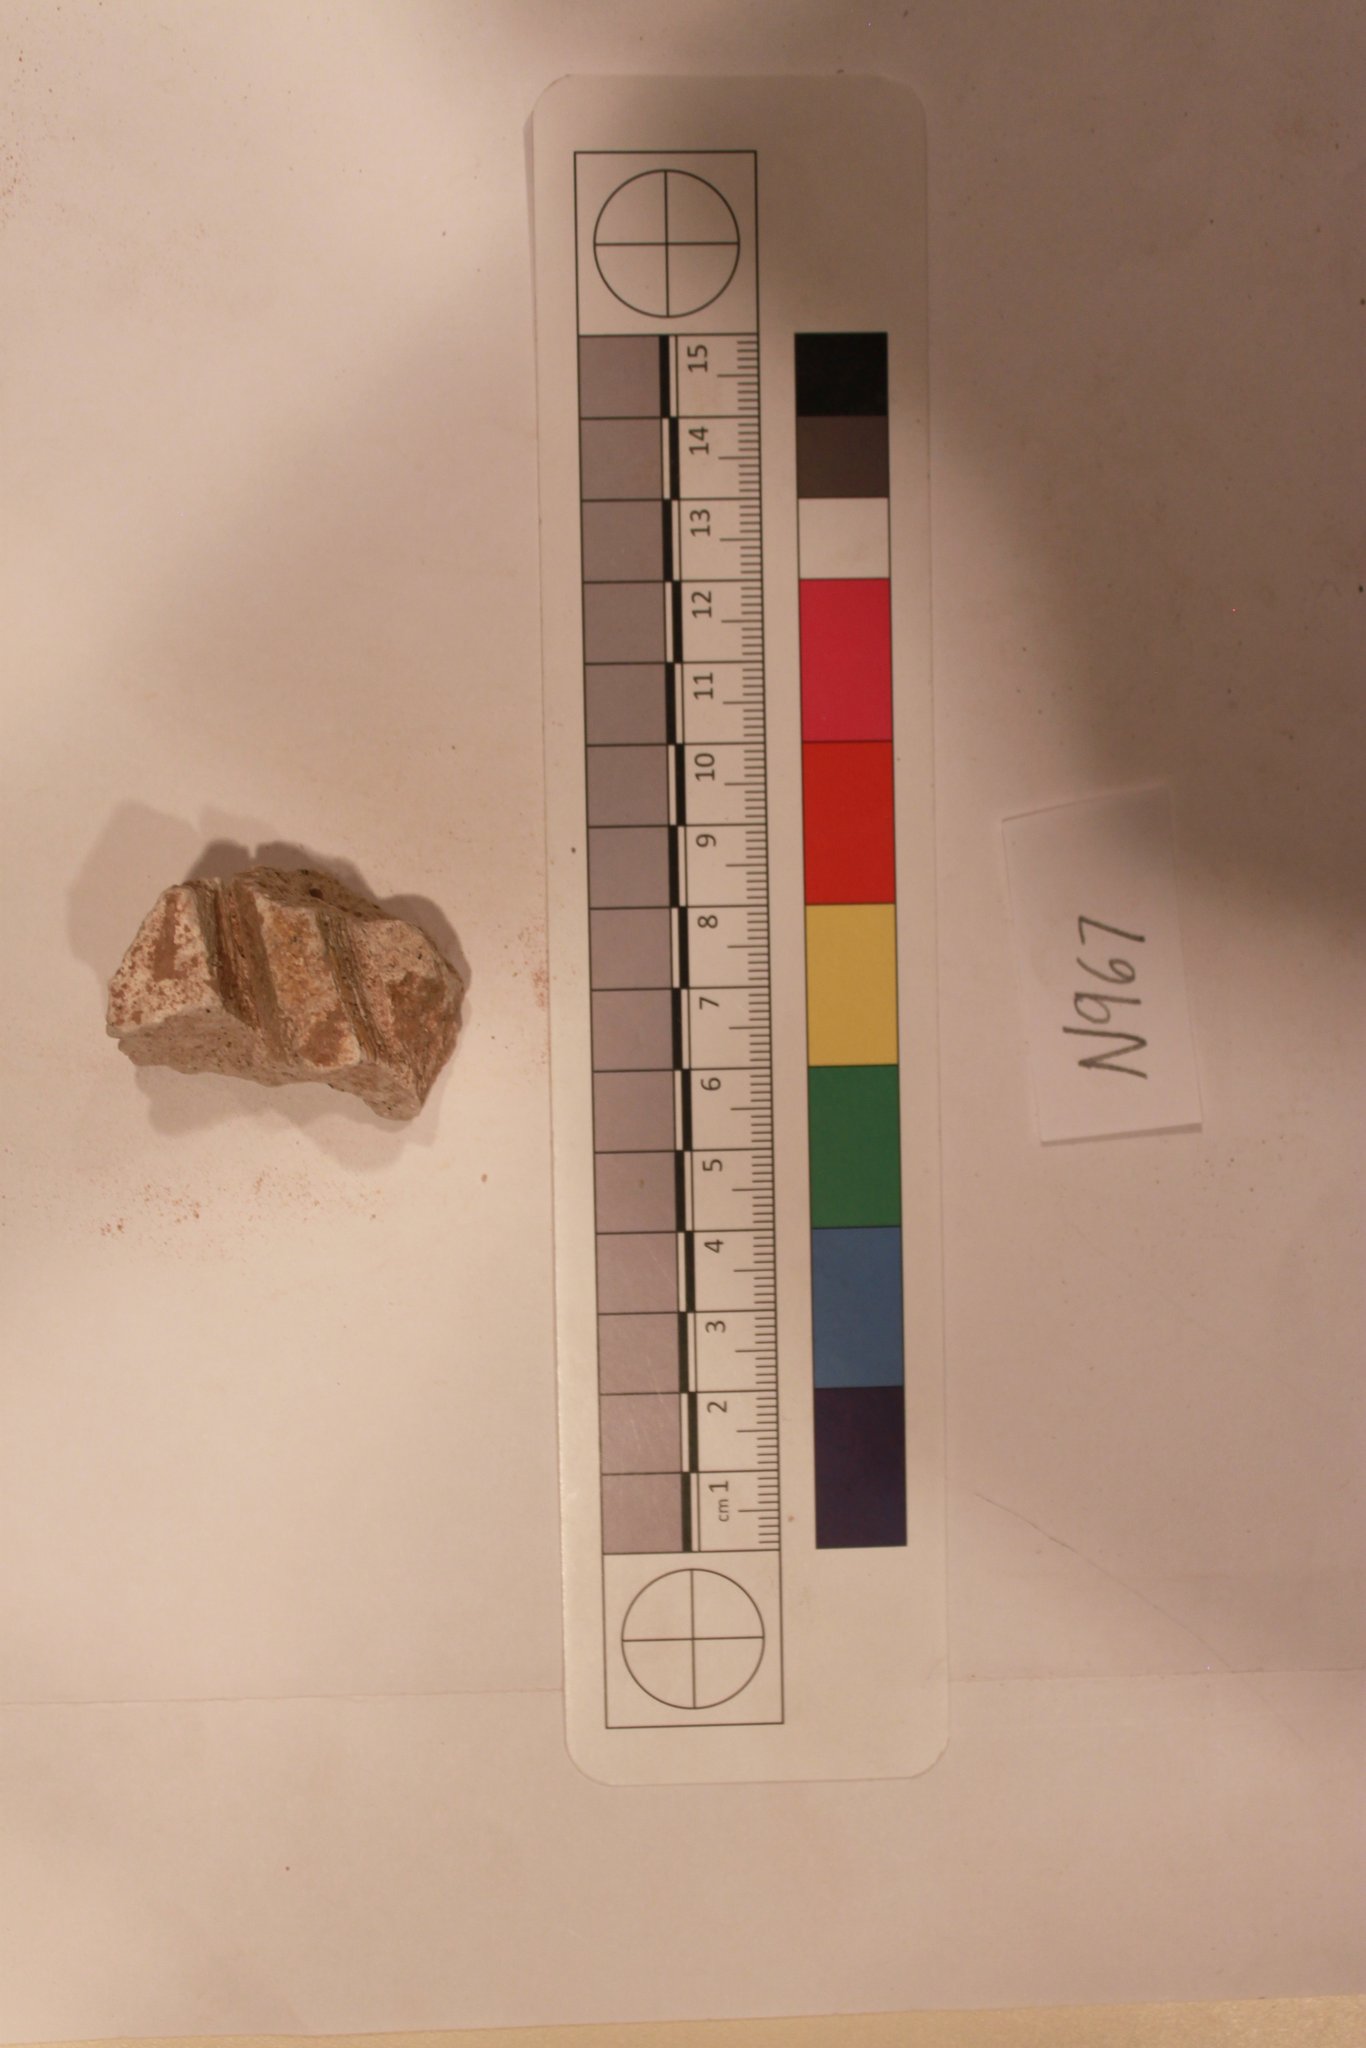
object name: fragment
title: Stucco Fragment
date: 701-1200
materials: plaster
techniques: carving, painting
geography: iran